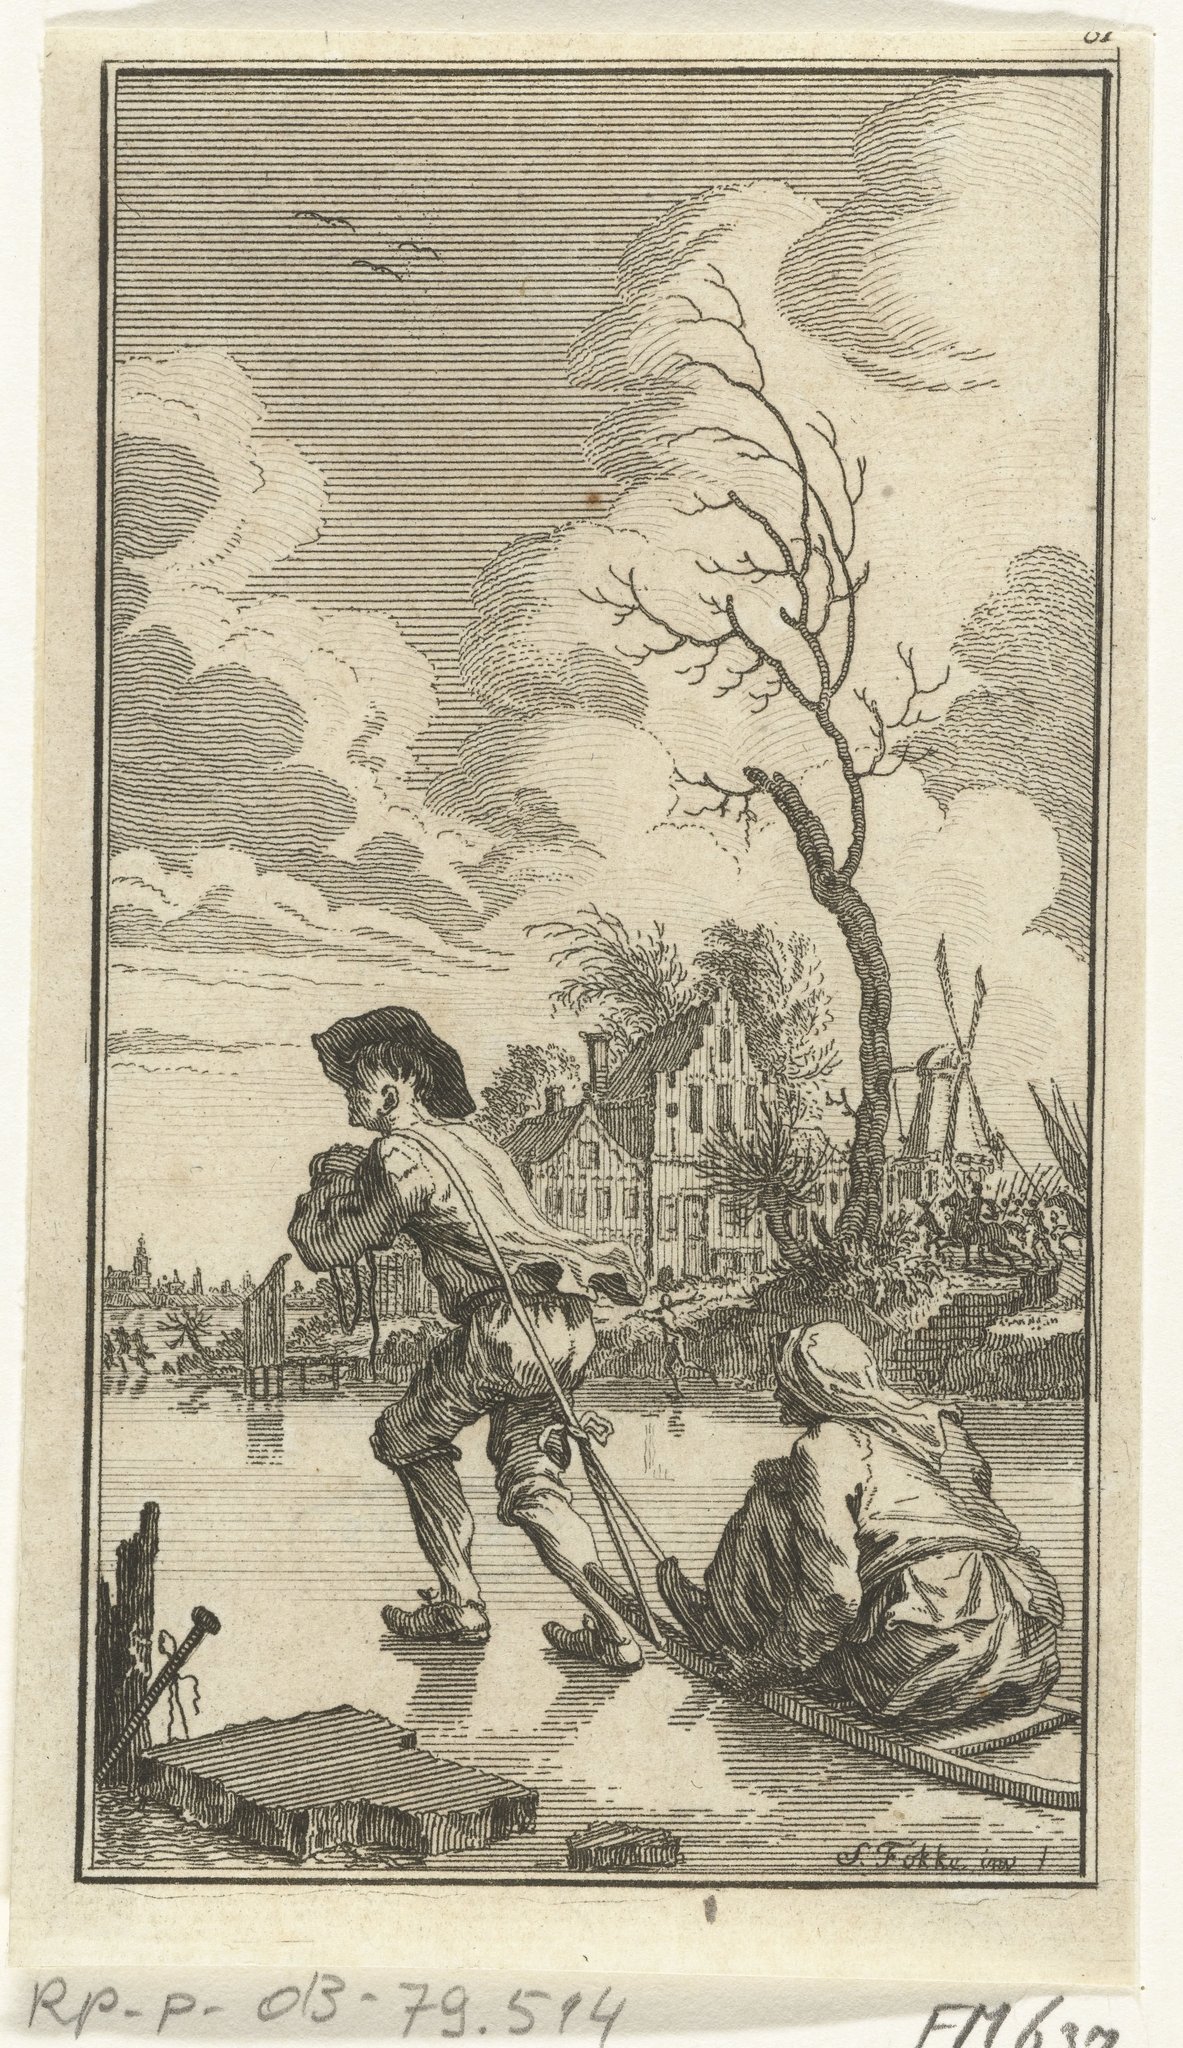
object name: history print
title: Lambert Melisz. vlucht met zijn moeder in een slee over het ijs, 1574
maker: simon fokke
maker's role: draughtsman, print maker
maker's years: 1712-1784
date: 1740-1742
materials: paper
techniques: etching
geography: northern netherlands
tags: sleigh, sledge (non-sport)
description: Gebruikt als illustratie in: Pieter Jansz Twisck, Een vaderlyk geschenk, of Testament : Zynde een verklaringe over het vyfde gebodt, Jacob Duyn te Hoorn en Jan Hartig te Amsterdam, 1742.